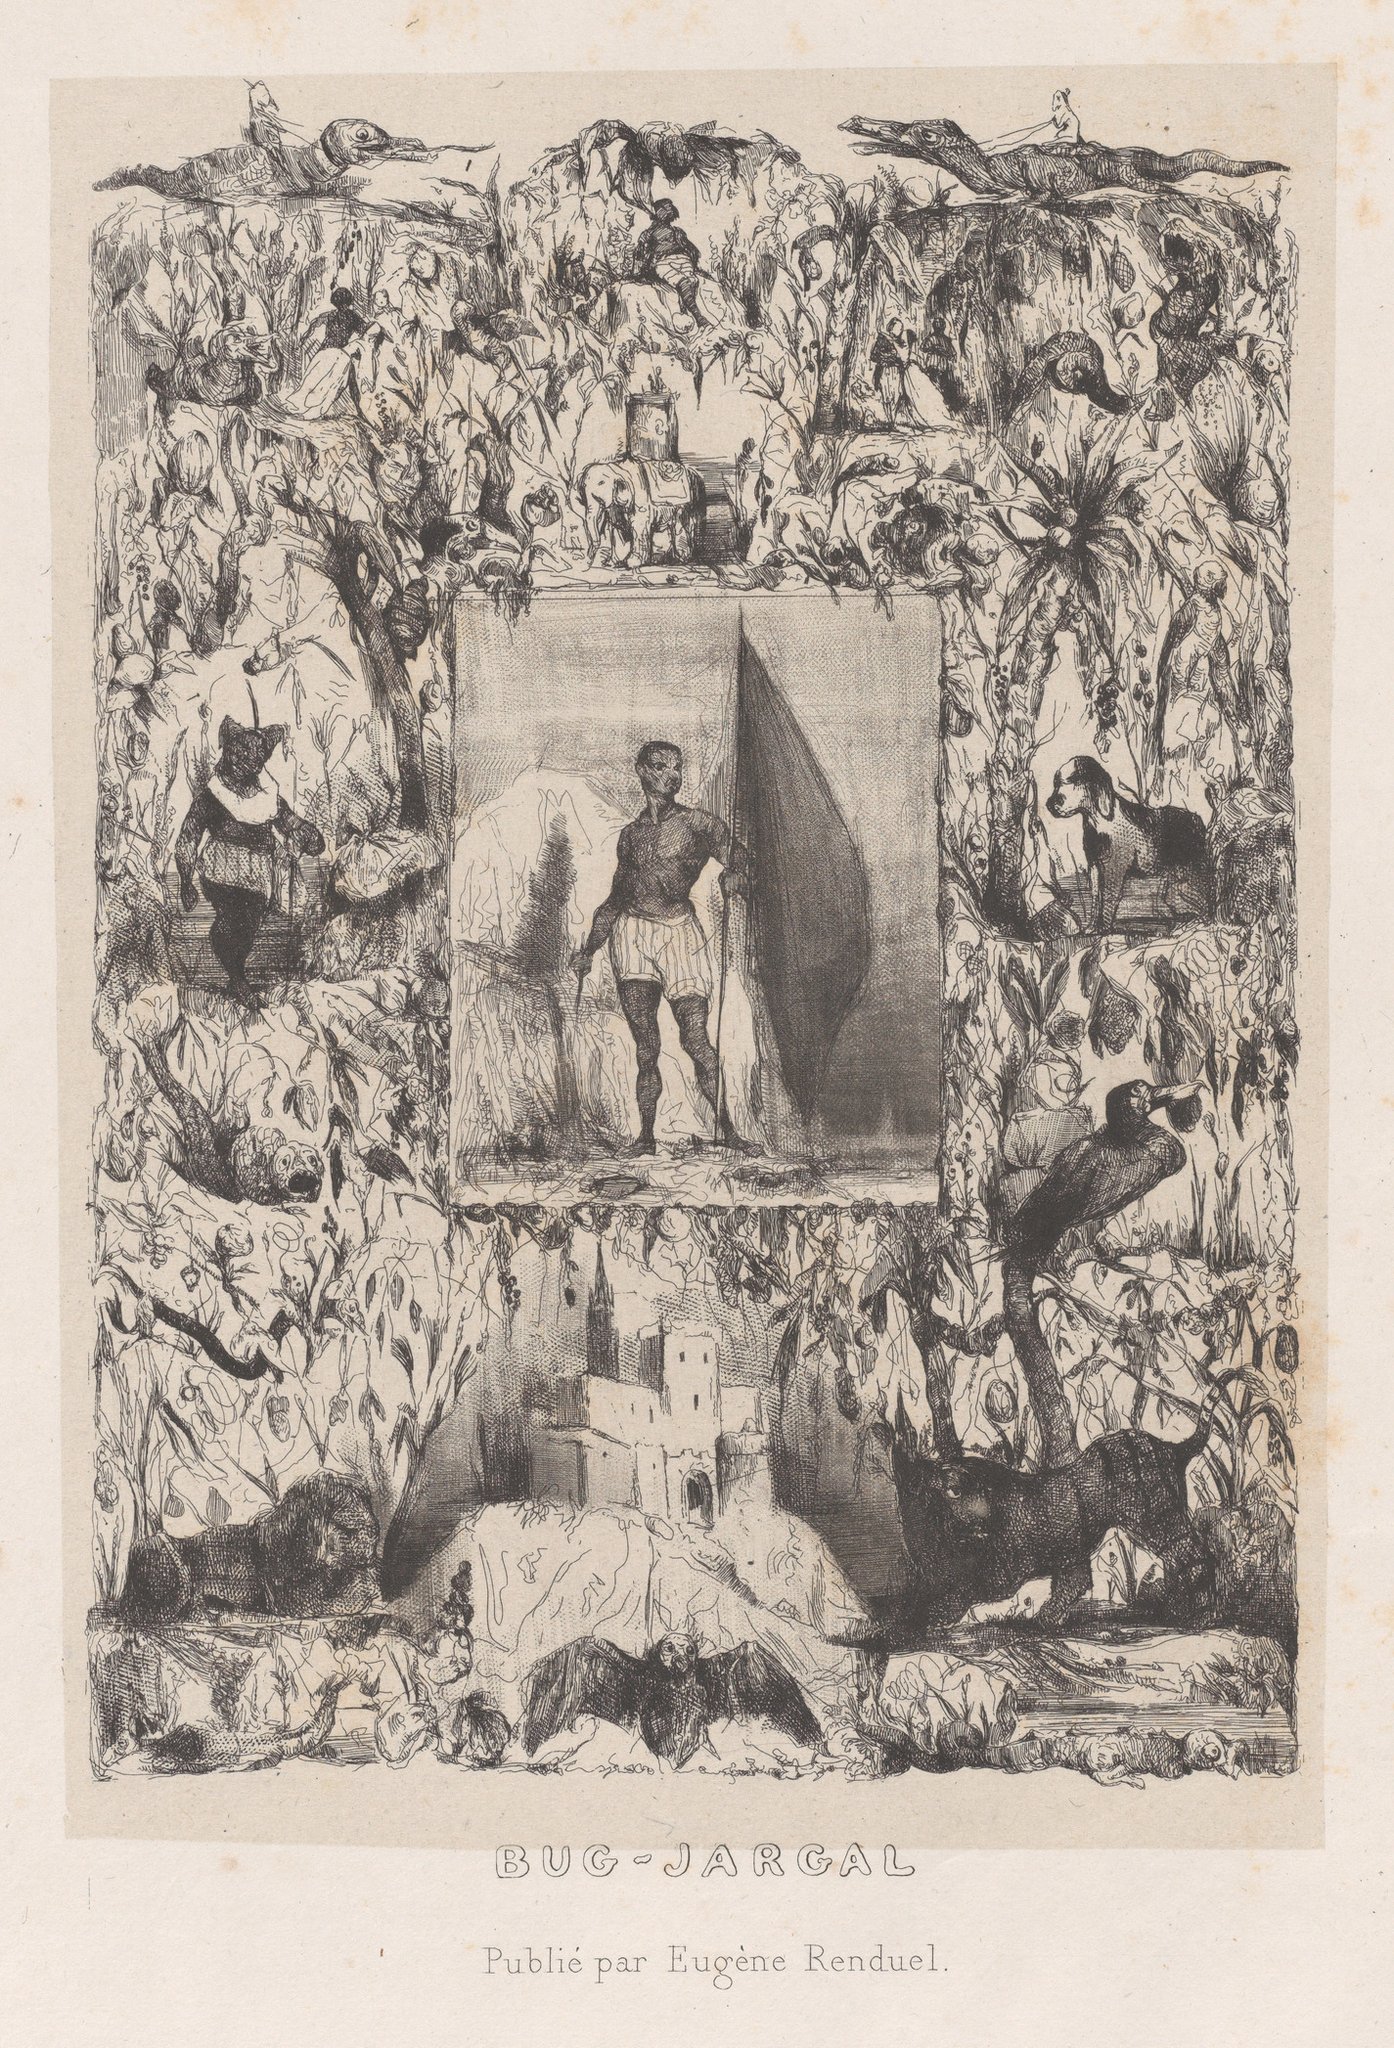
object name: print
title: Bug-Jargal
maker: célestin nanteuil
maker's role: artist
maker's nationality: french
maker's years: 1813-1873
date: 1832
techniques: etching